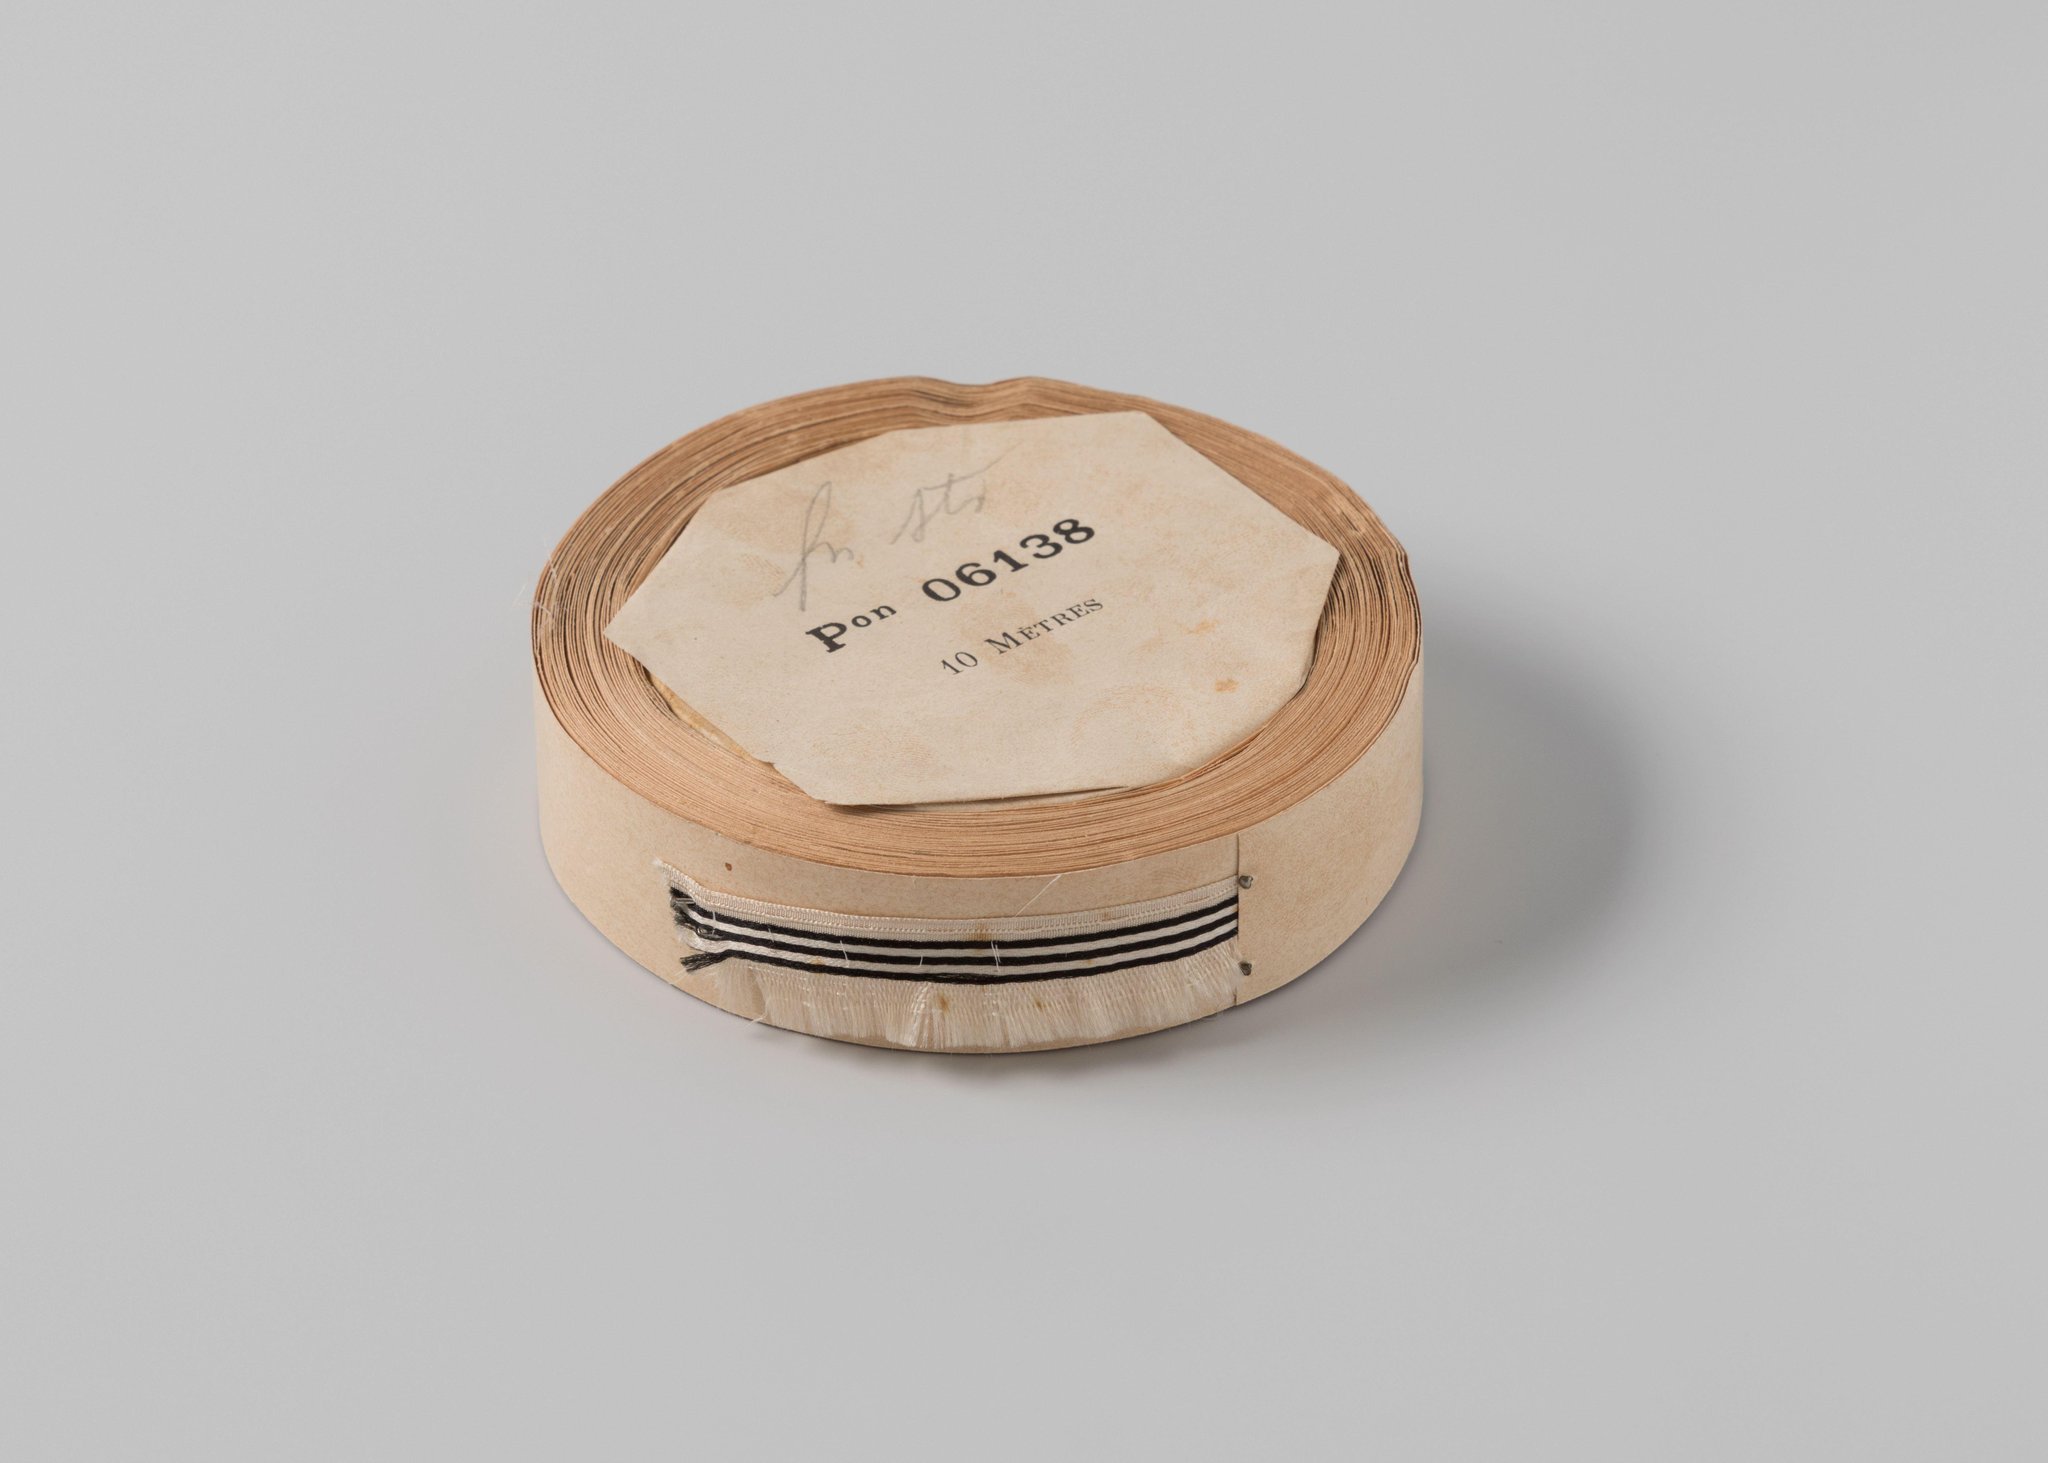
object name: ribbon material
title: Rol met wit lint met één gerafelde zijde en drie zwarte horizontale strepen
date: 1930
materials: cardboard, paper, textile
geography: nijmegen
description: Rol met wit lint met één gerafelde zijde en drie zwarte horizontale strepen.